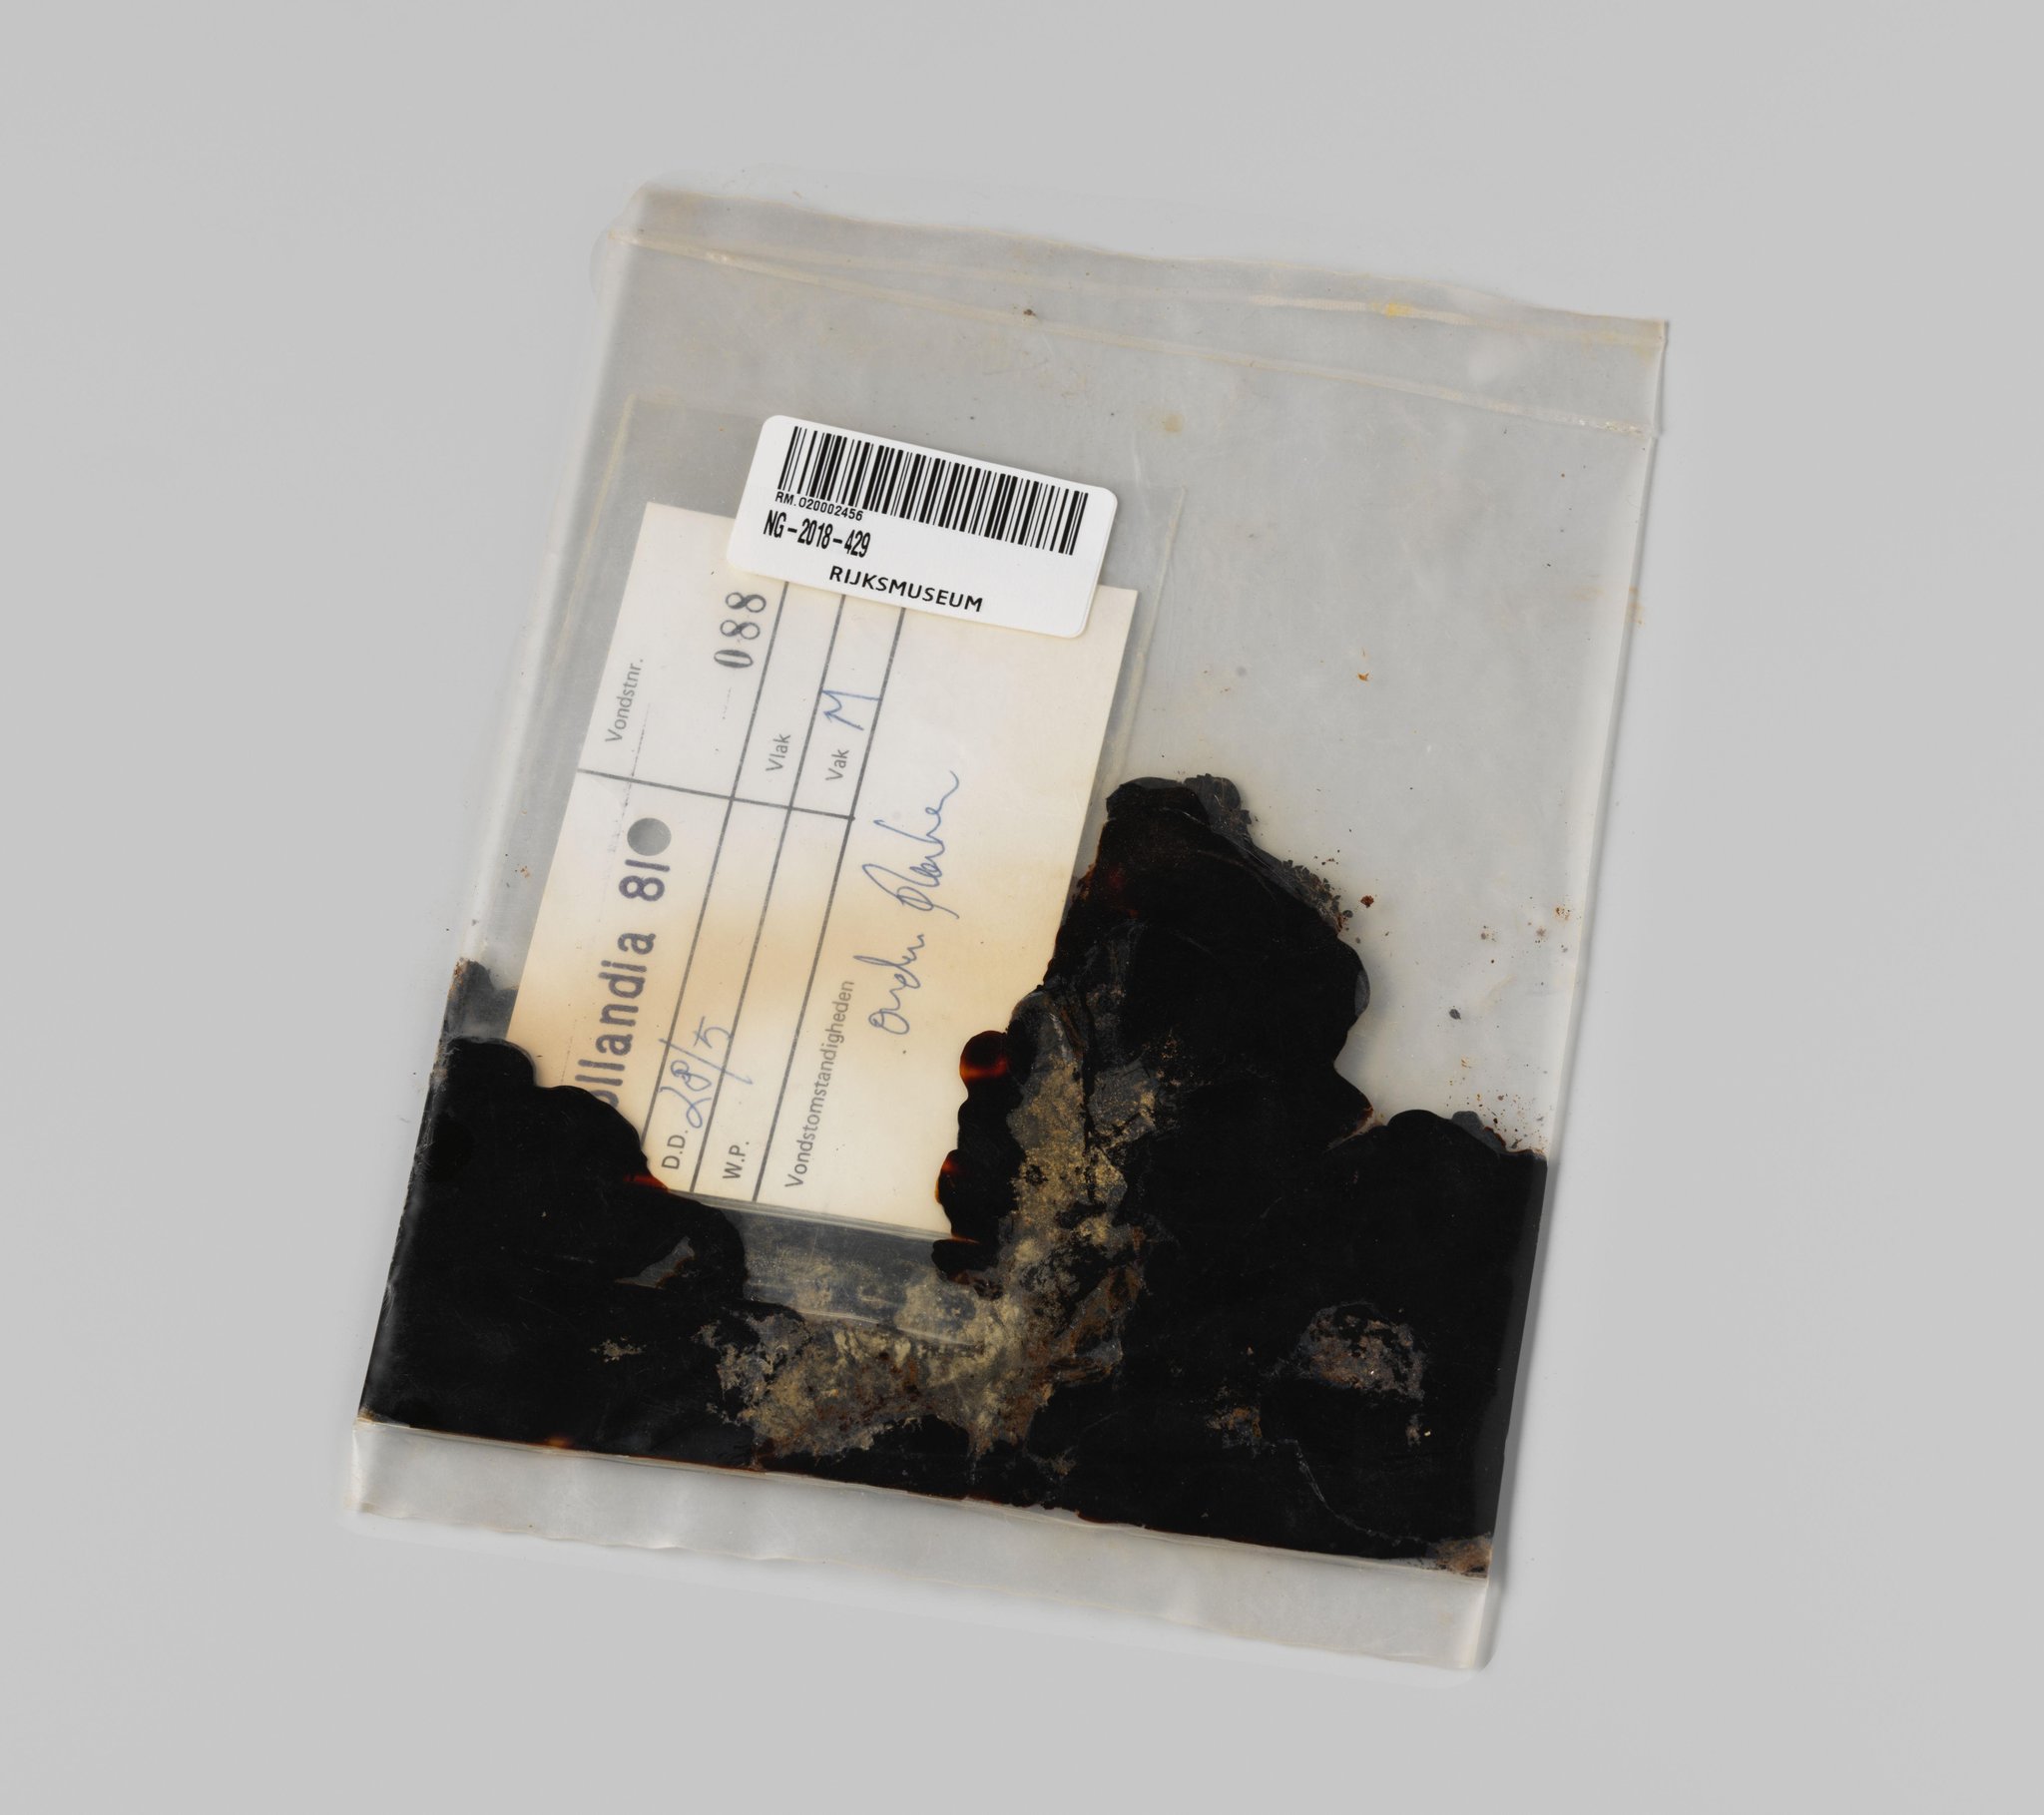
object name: plaatwerk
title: Plaatwerk (hout?) uit het wrak van de Oostindiëvaarder Hollandia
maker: Anonymous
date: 1700-1743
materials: pitch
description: Plaatwerk (hout?), omringd door vermoedelijk veel PEG.